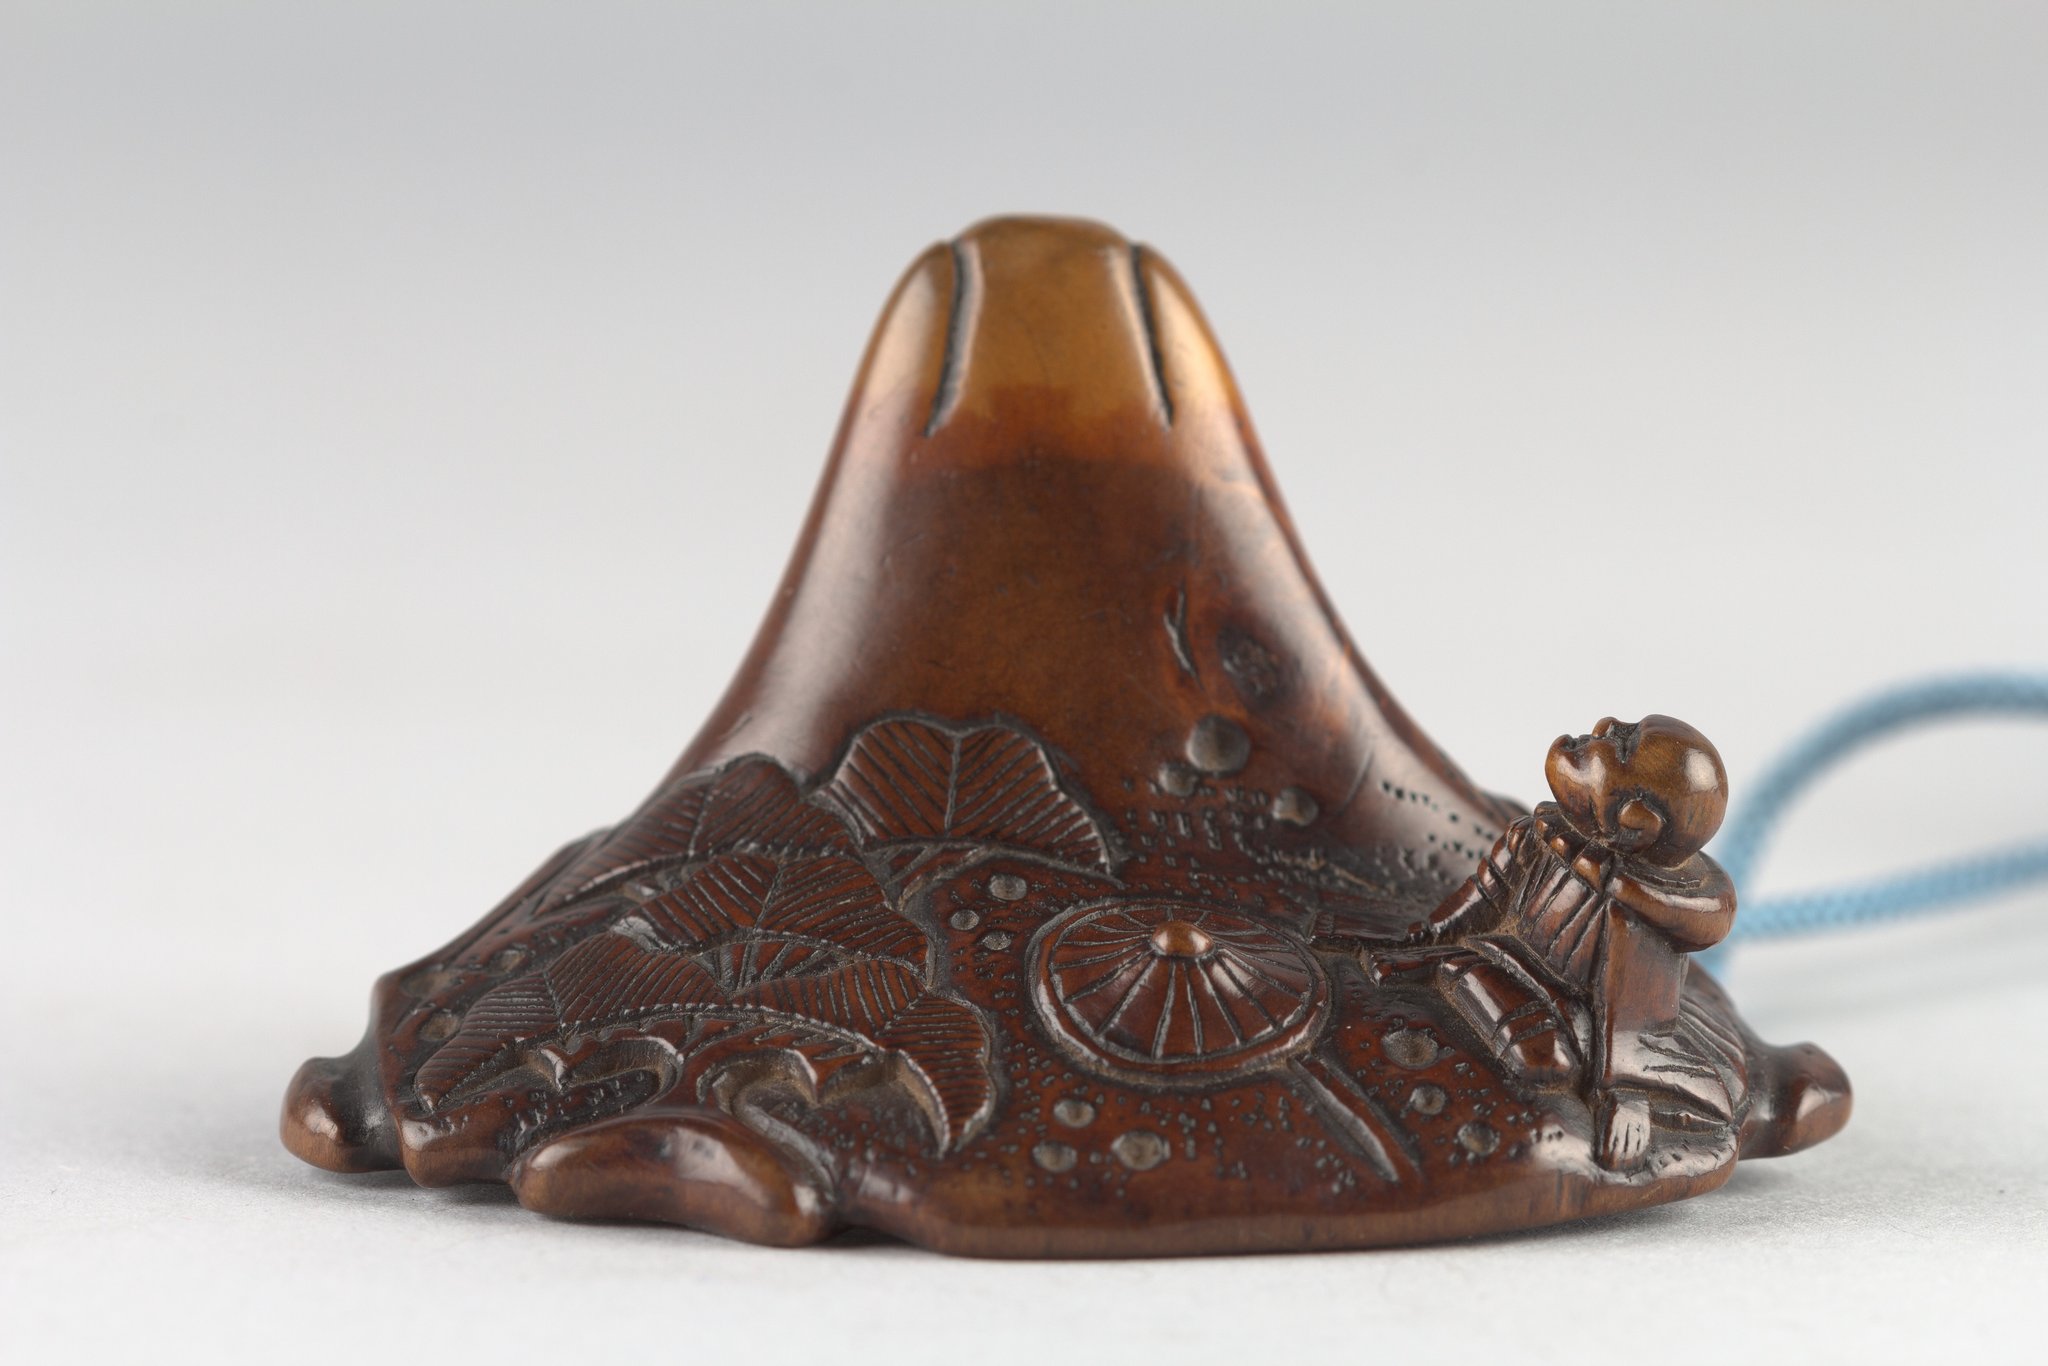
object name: netsuke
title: Netsuke in shape of Mount Fuji with Traveling Monk and Pine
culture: japanese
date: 1801-1900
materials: wood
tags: mountains,monks